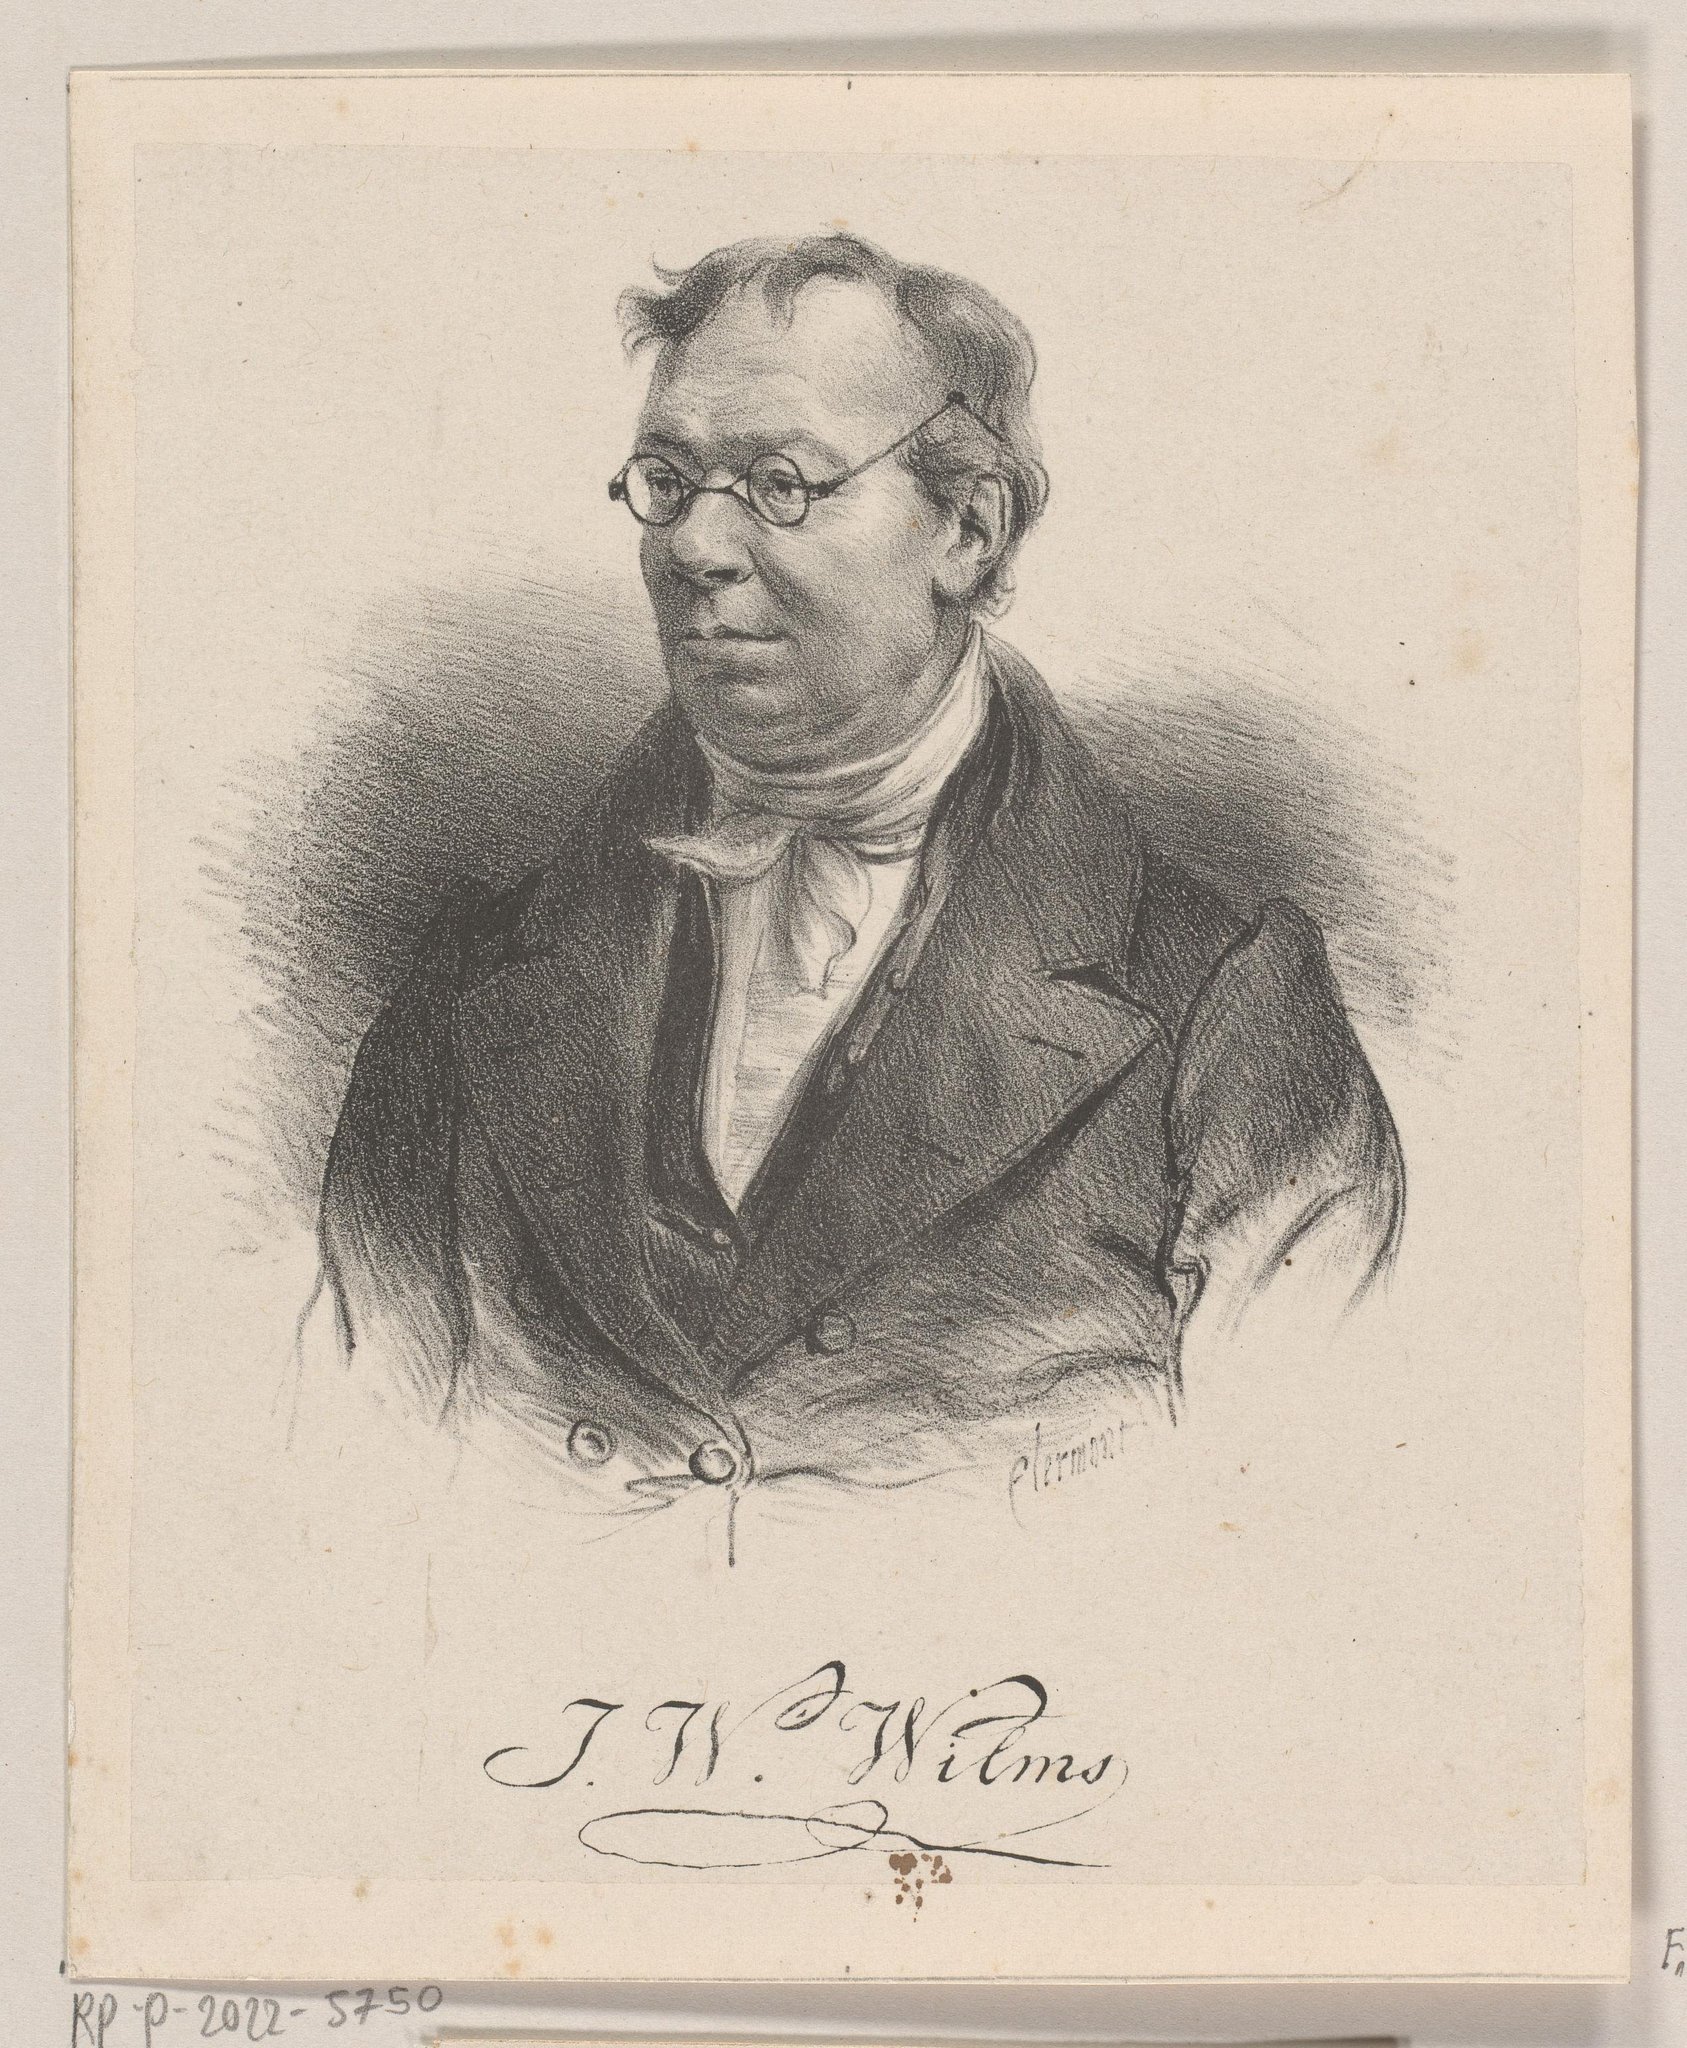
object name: print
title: Portret van Johan Wilhelm Wilms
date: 1835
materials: paper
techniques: lithograph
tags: amsterdam, historical persons, portrait of composer, book